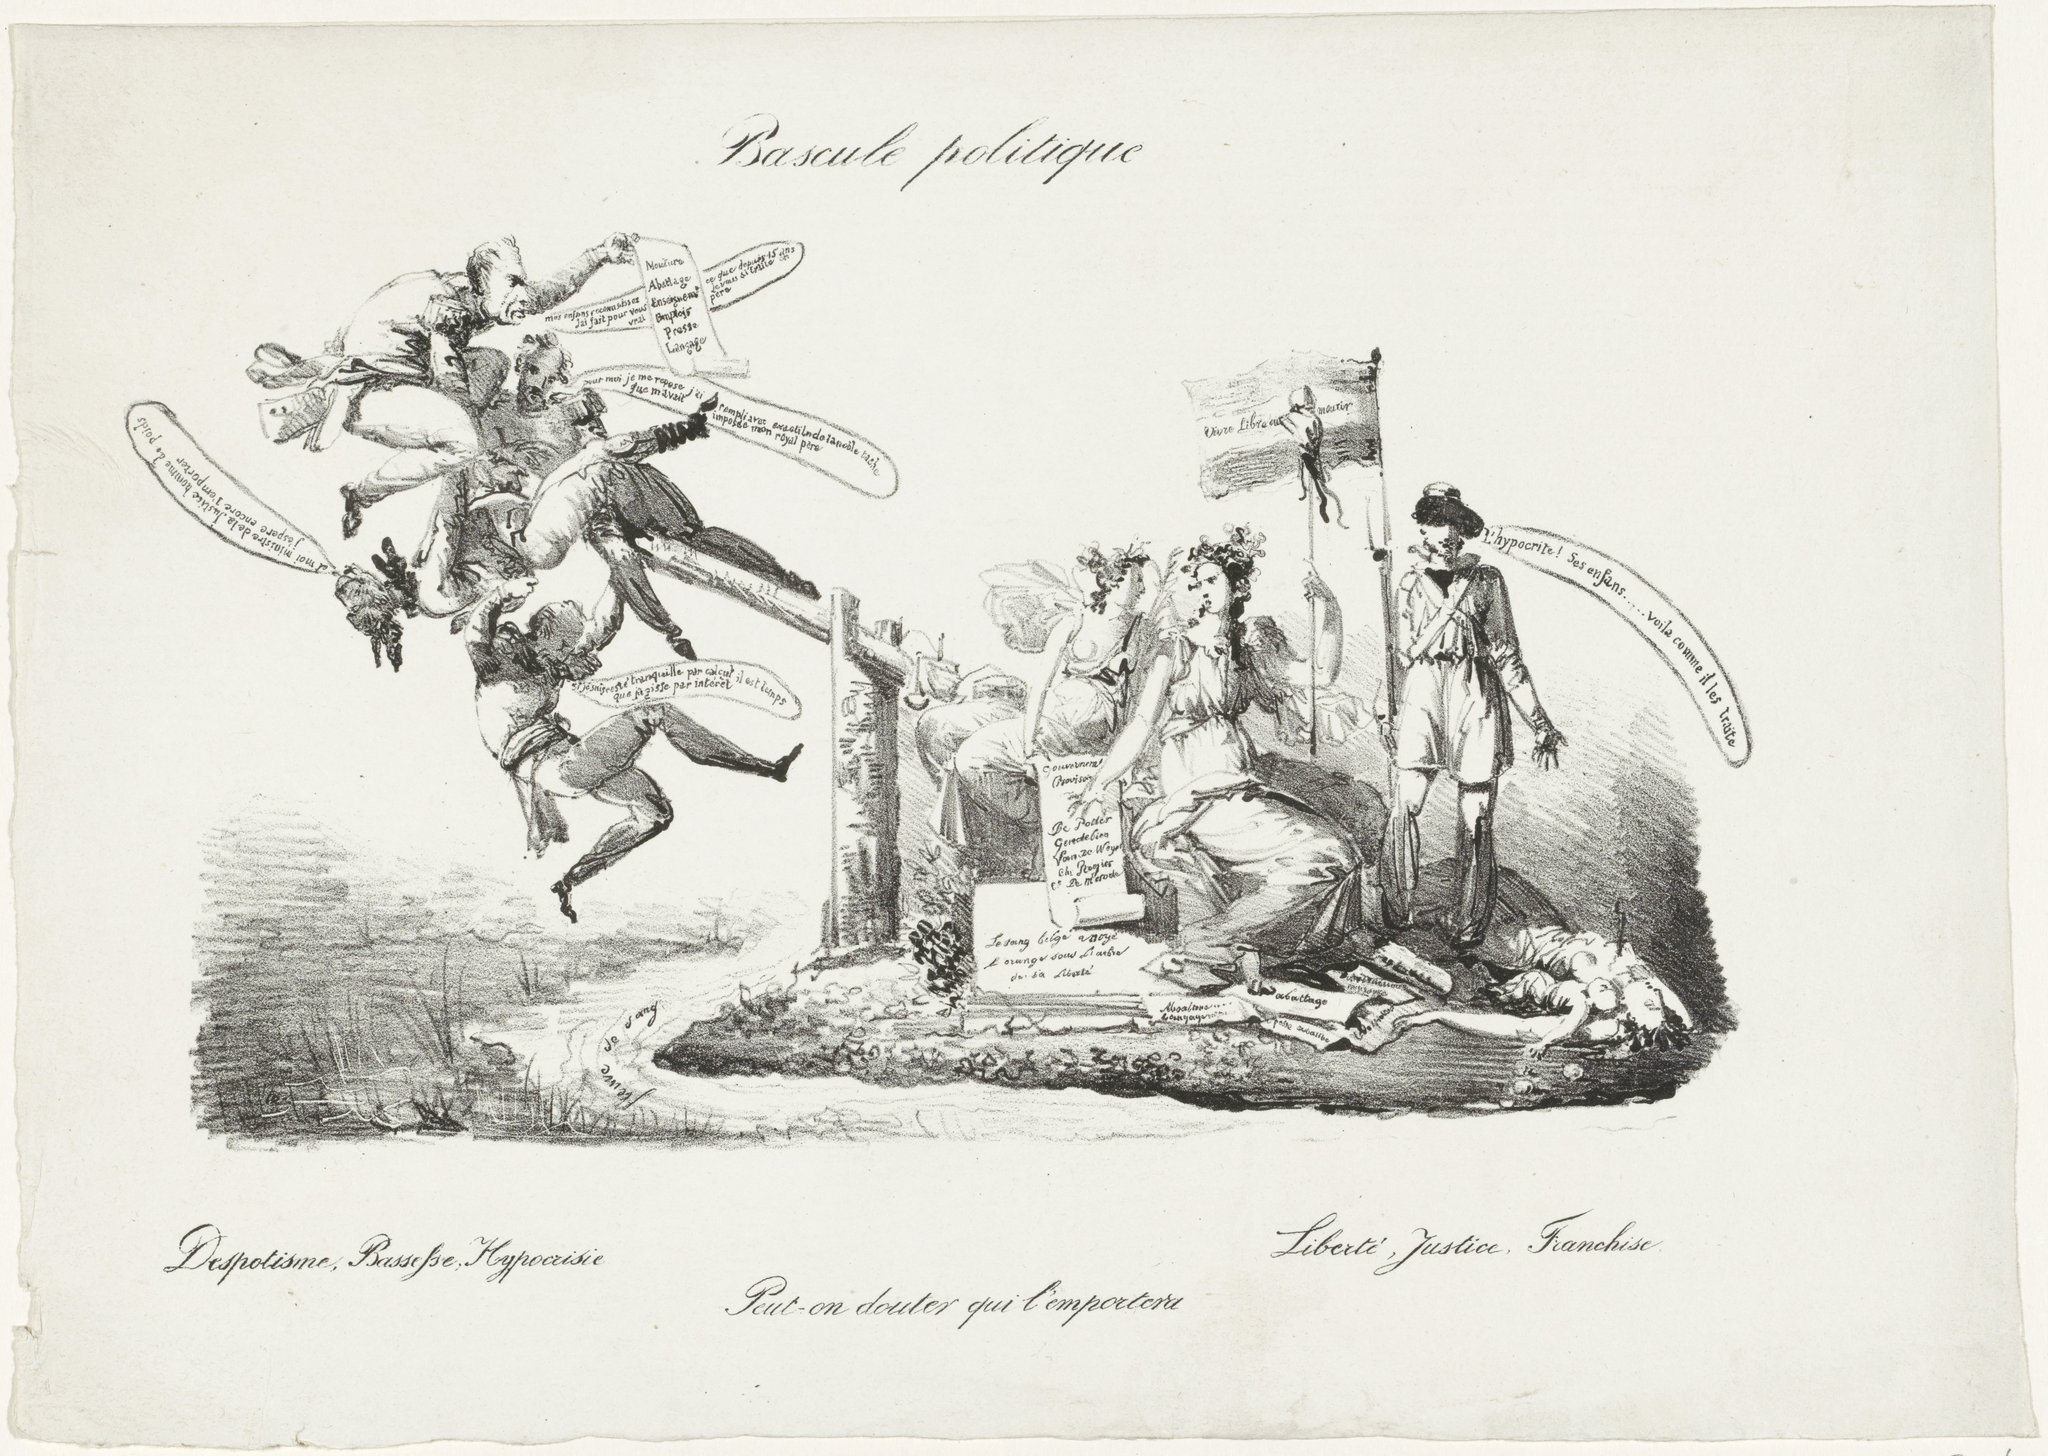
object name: cartoon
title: Bascule politique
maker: Anonymous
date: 1830-1831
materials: paper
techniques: lithograph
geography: belgium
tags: the hague, berlin, william i of the netherlands, william ii of the netherlands, printer, publisher, cheese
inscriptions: collector's mark: Lugt 2228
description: Spotprent met de Nederlanders en de Belgen op een wip. Aan de linkerkant hangen, boven een rivier van bloed, koning Willem I, prins Frederik, de kroonprins en minister Van Maanen, in het onderschrift aangeduid als 'Depotisme, Bassesse, Hypocrisie'. Aan de rechterkant, die zwaarder is, zitten de Vrijheid en de Belgische Maagd met een document verwijzend naar het Voorlopige Bewind. Rechts staat een opstandeling met de Belgische vlag, hij wijst naar de lichamen van een dode moeder met kind op de grond.